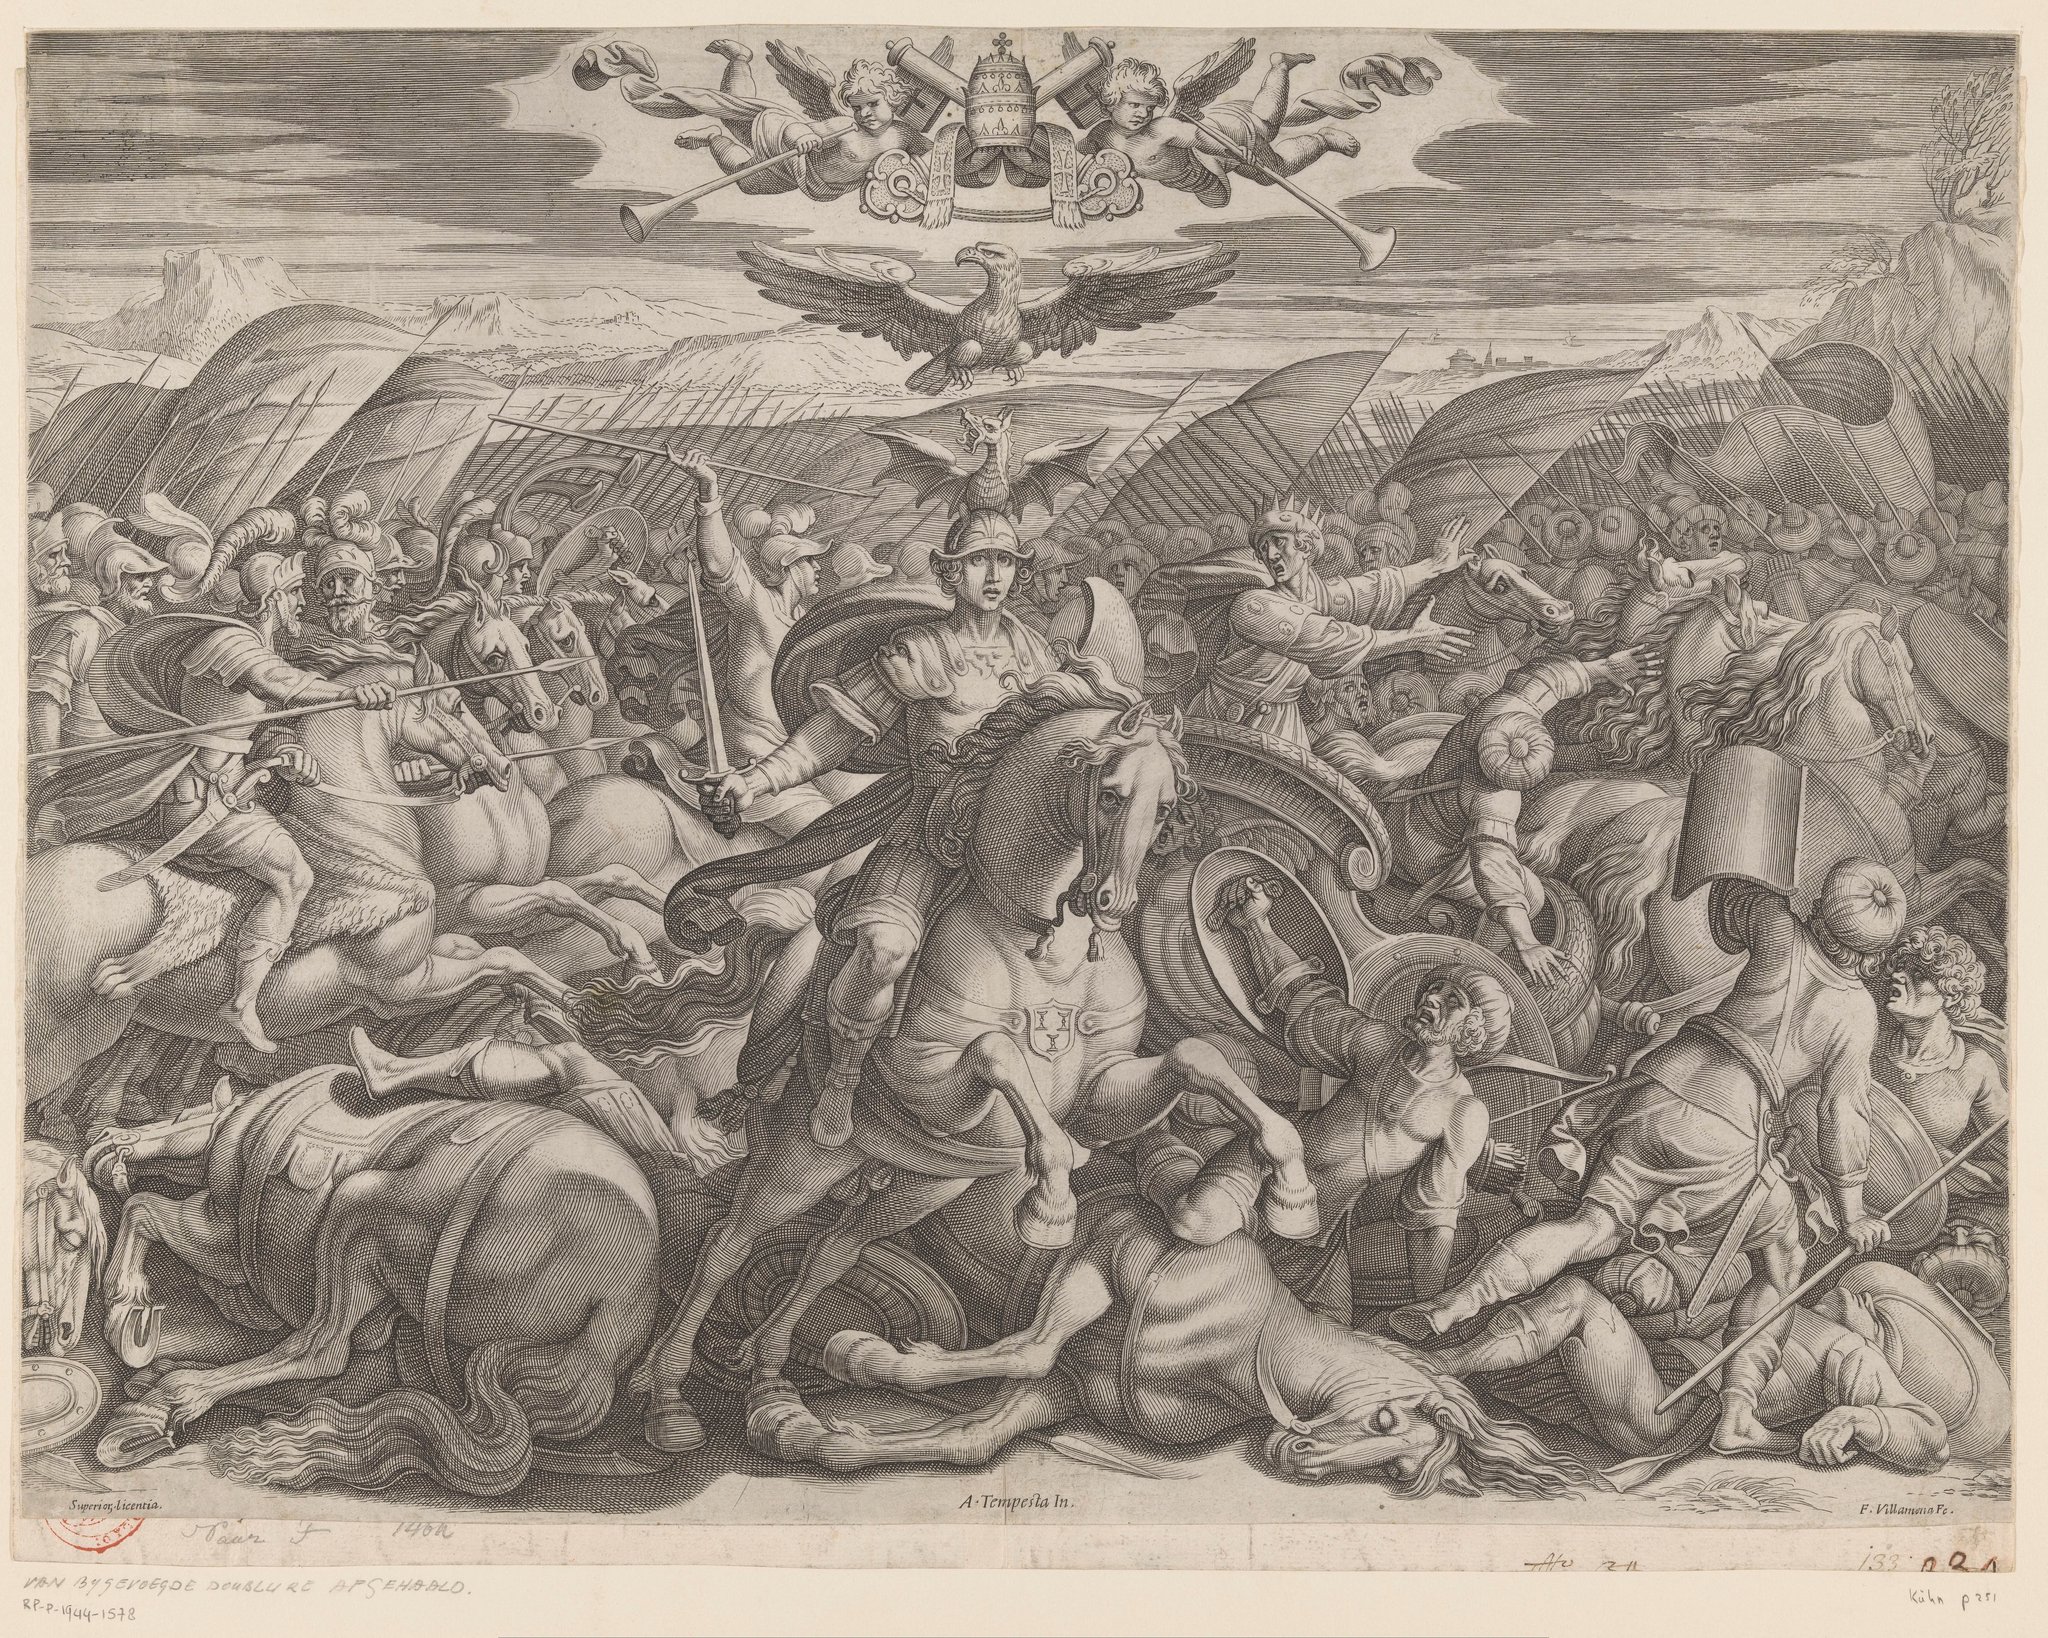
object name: print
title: Slag bij Gaugamela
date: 1576-1624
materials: paper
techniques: engraving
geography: vatican city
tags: persia, battle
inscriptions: collector's mark: Lugt 2228, collector's mark: Lugt 240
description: Slag bij Gaugamela met links de Macedoniërs onder leiding van Alexander de Grote en rechts de Perzen onder leiding van koning Darius III.